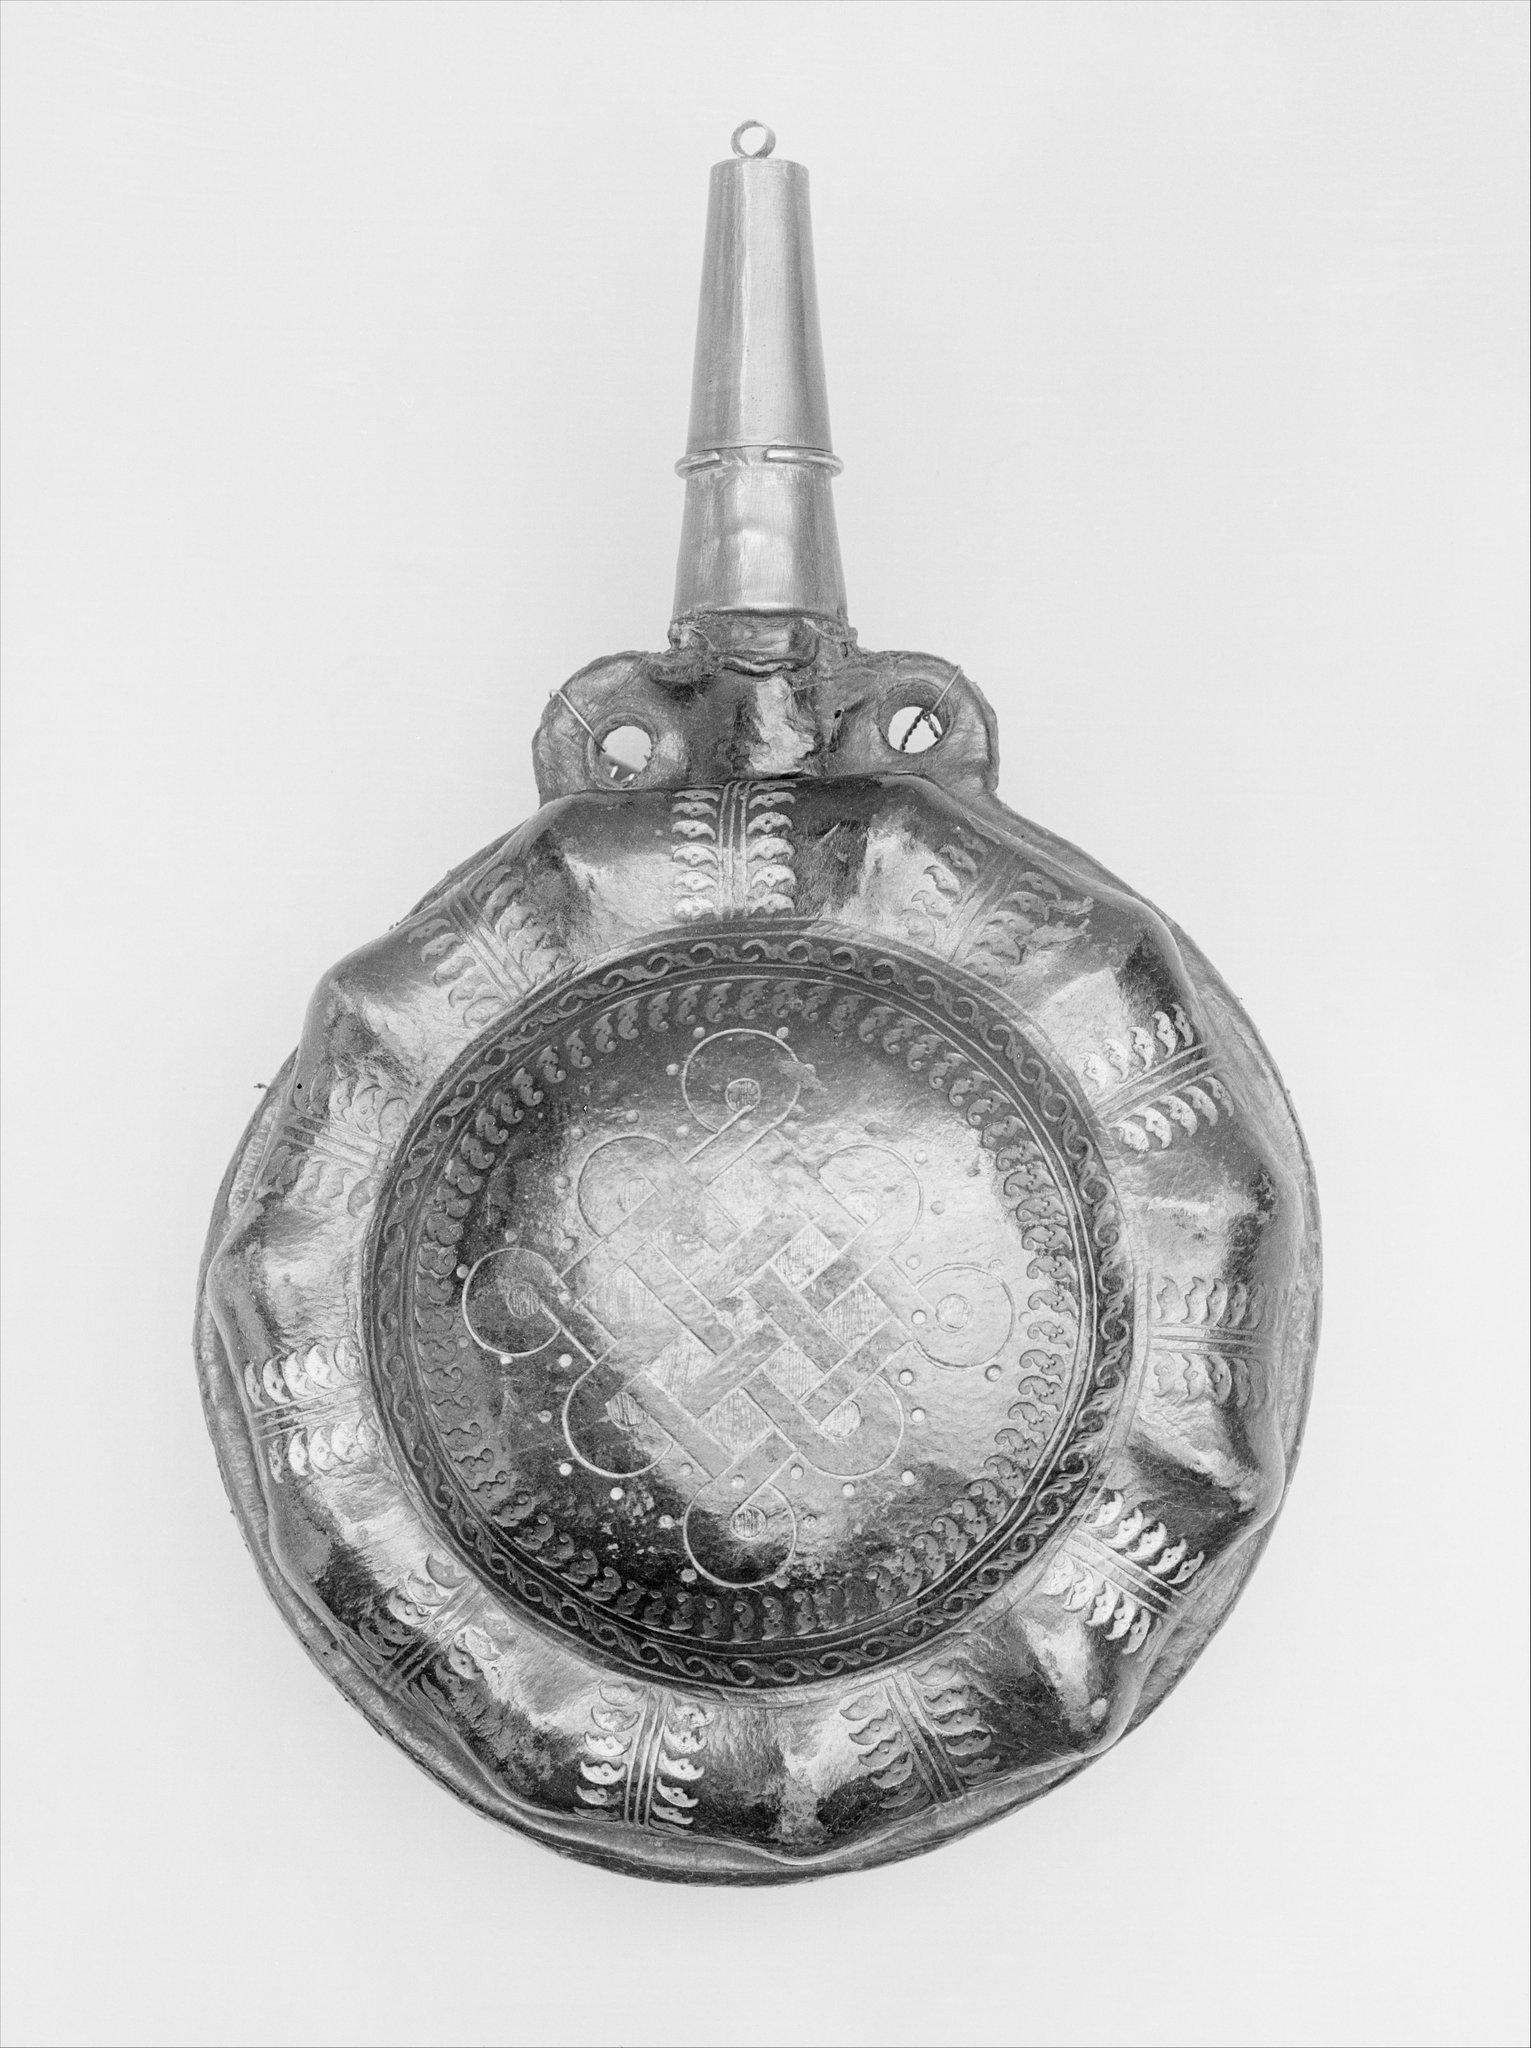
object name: powder flask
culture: italian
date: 1501-1600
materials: brass, gold, leather, pigment, thread, wood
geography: italy